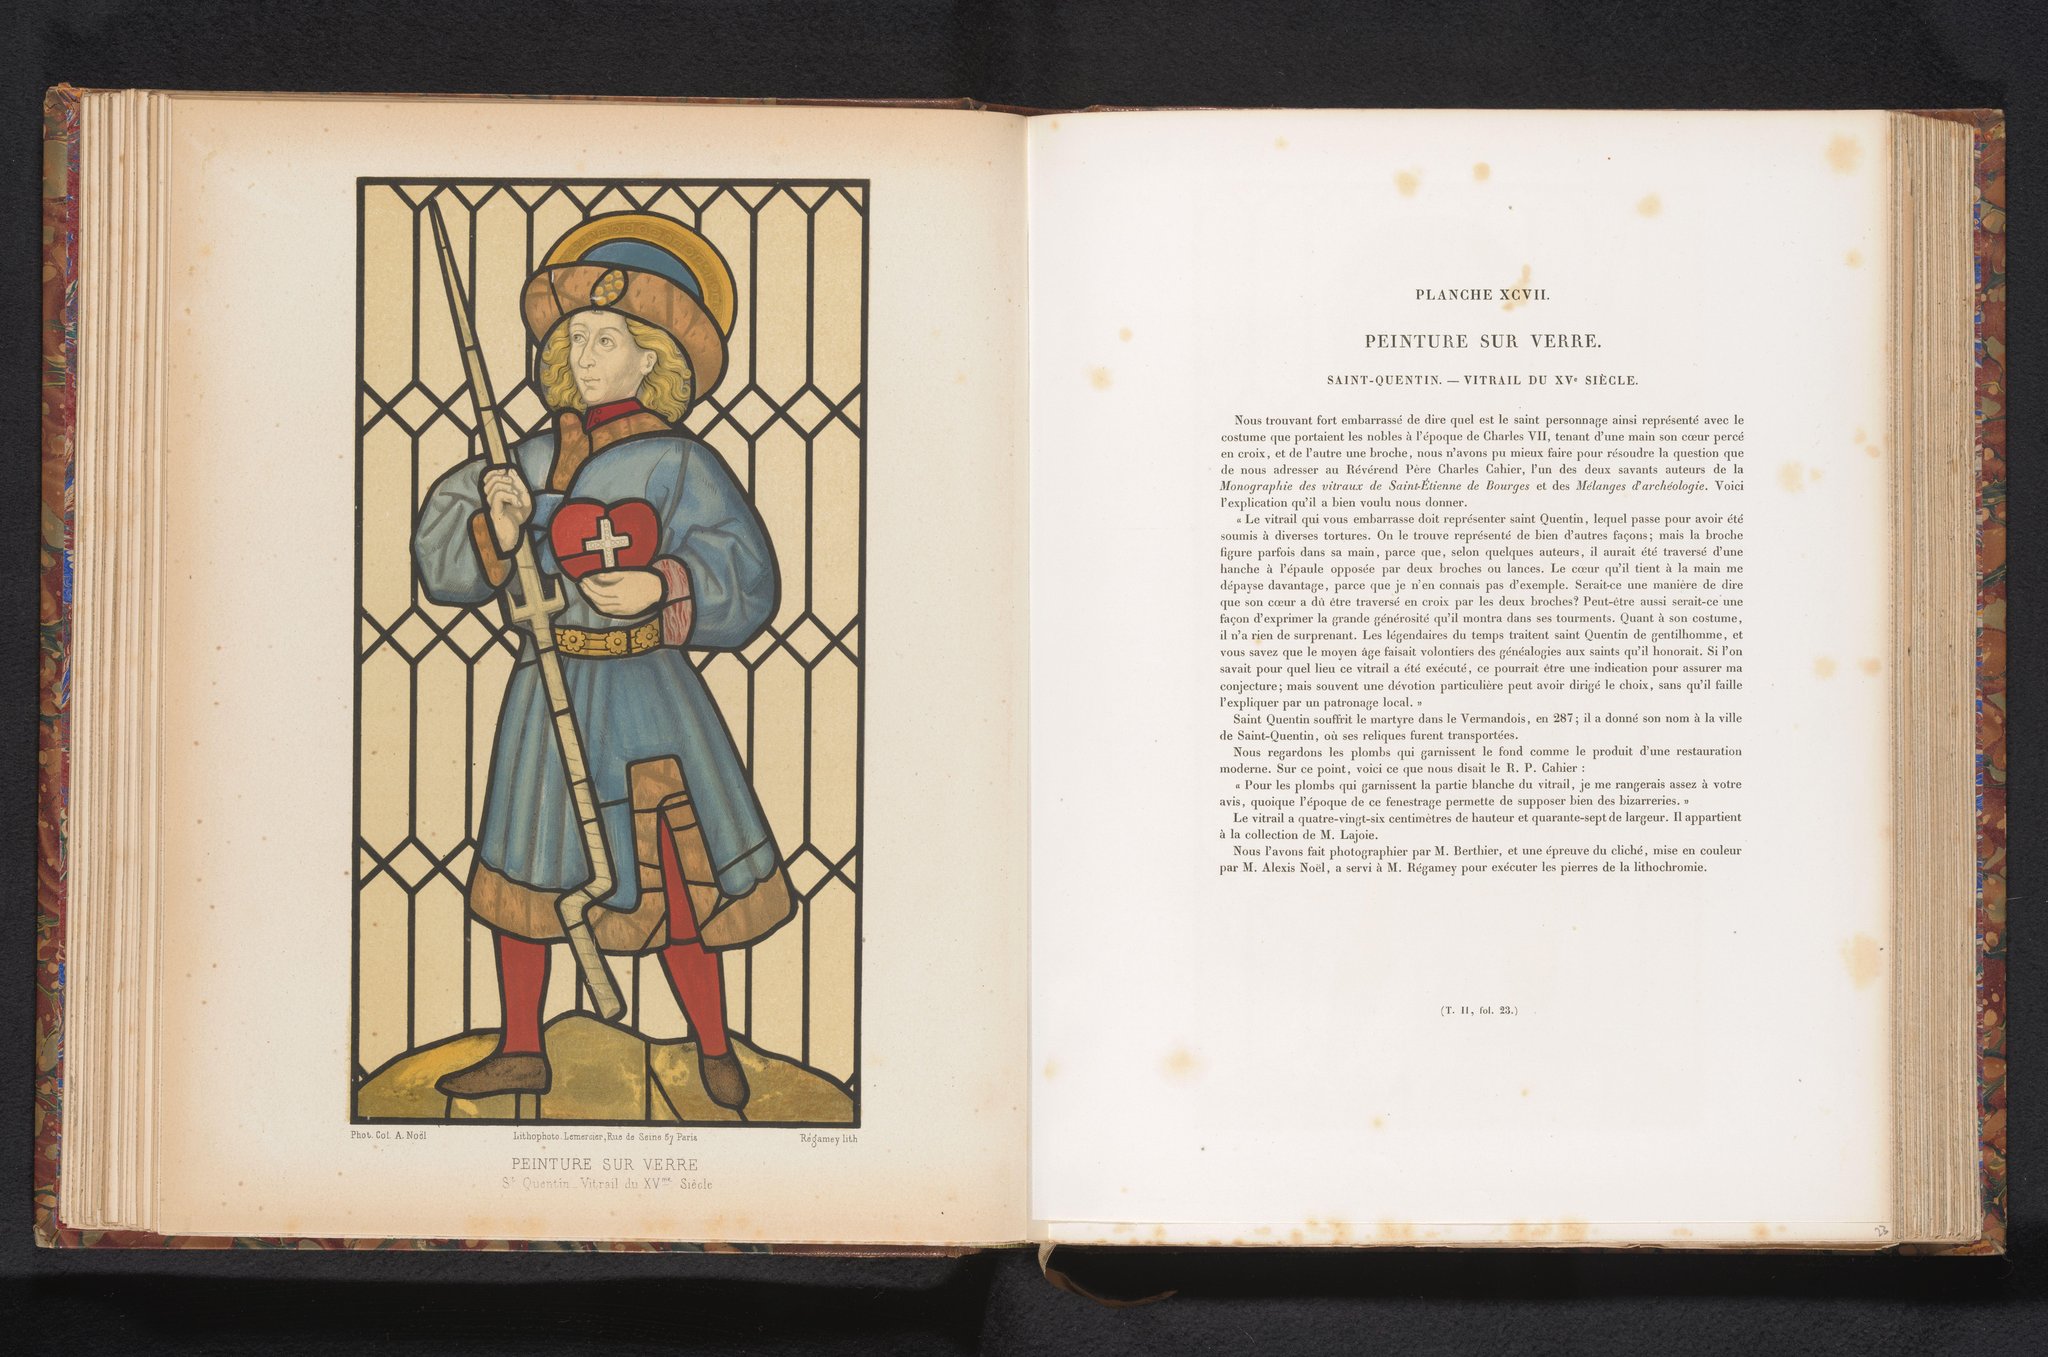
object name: reproduction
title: St. Quentin, Vitrail du XVme Siècle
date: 1859-1864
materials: paper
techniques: photolithography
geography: paris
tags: the martyr quintin(us) (quentin) of vermand; possible attributes: nail(s)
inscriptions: name: ‘Phot. col. A. Noël/ Régamey lith’